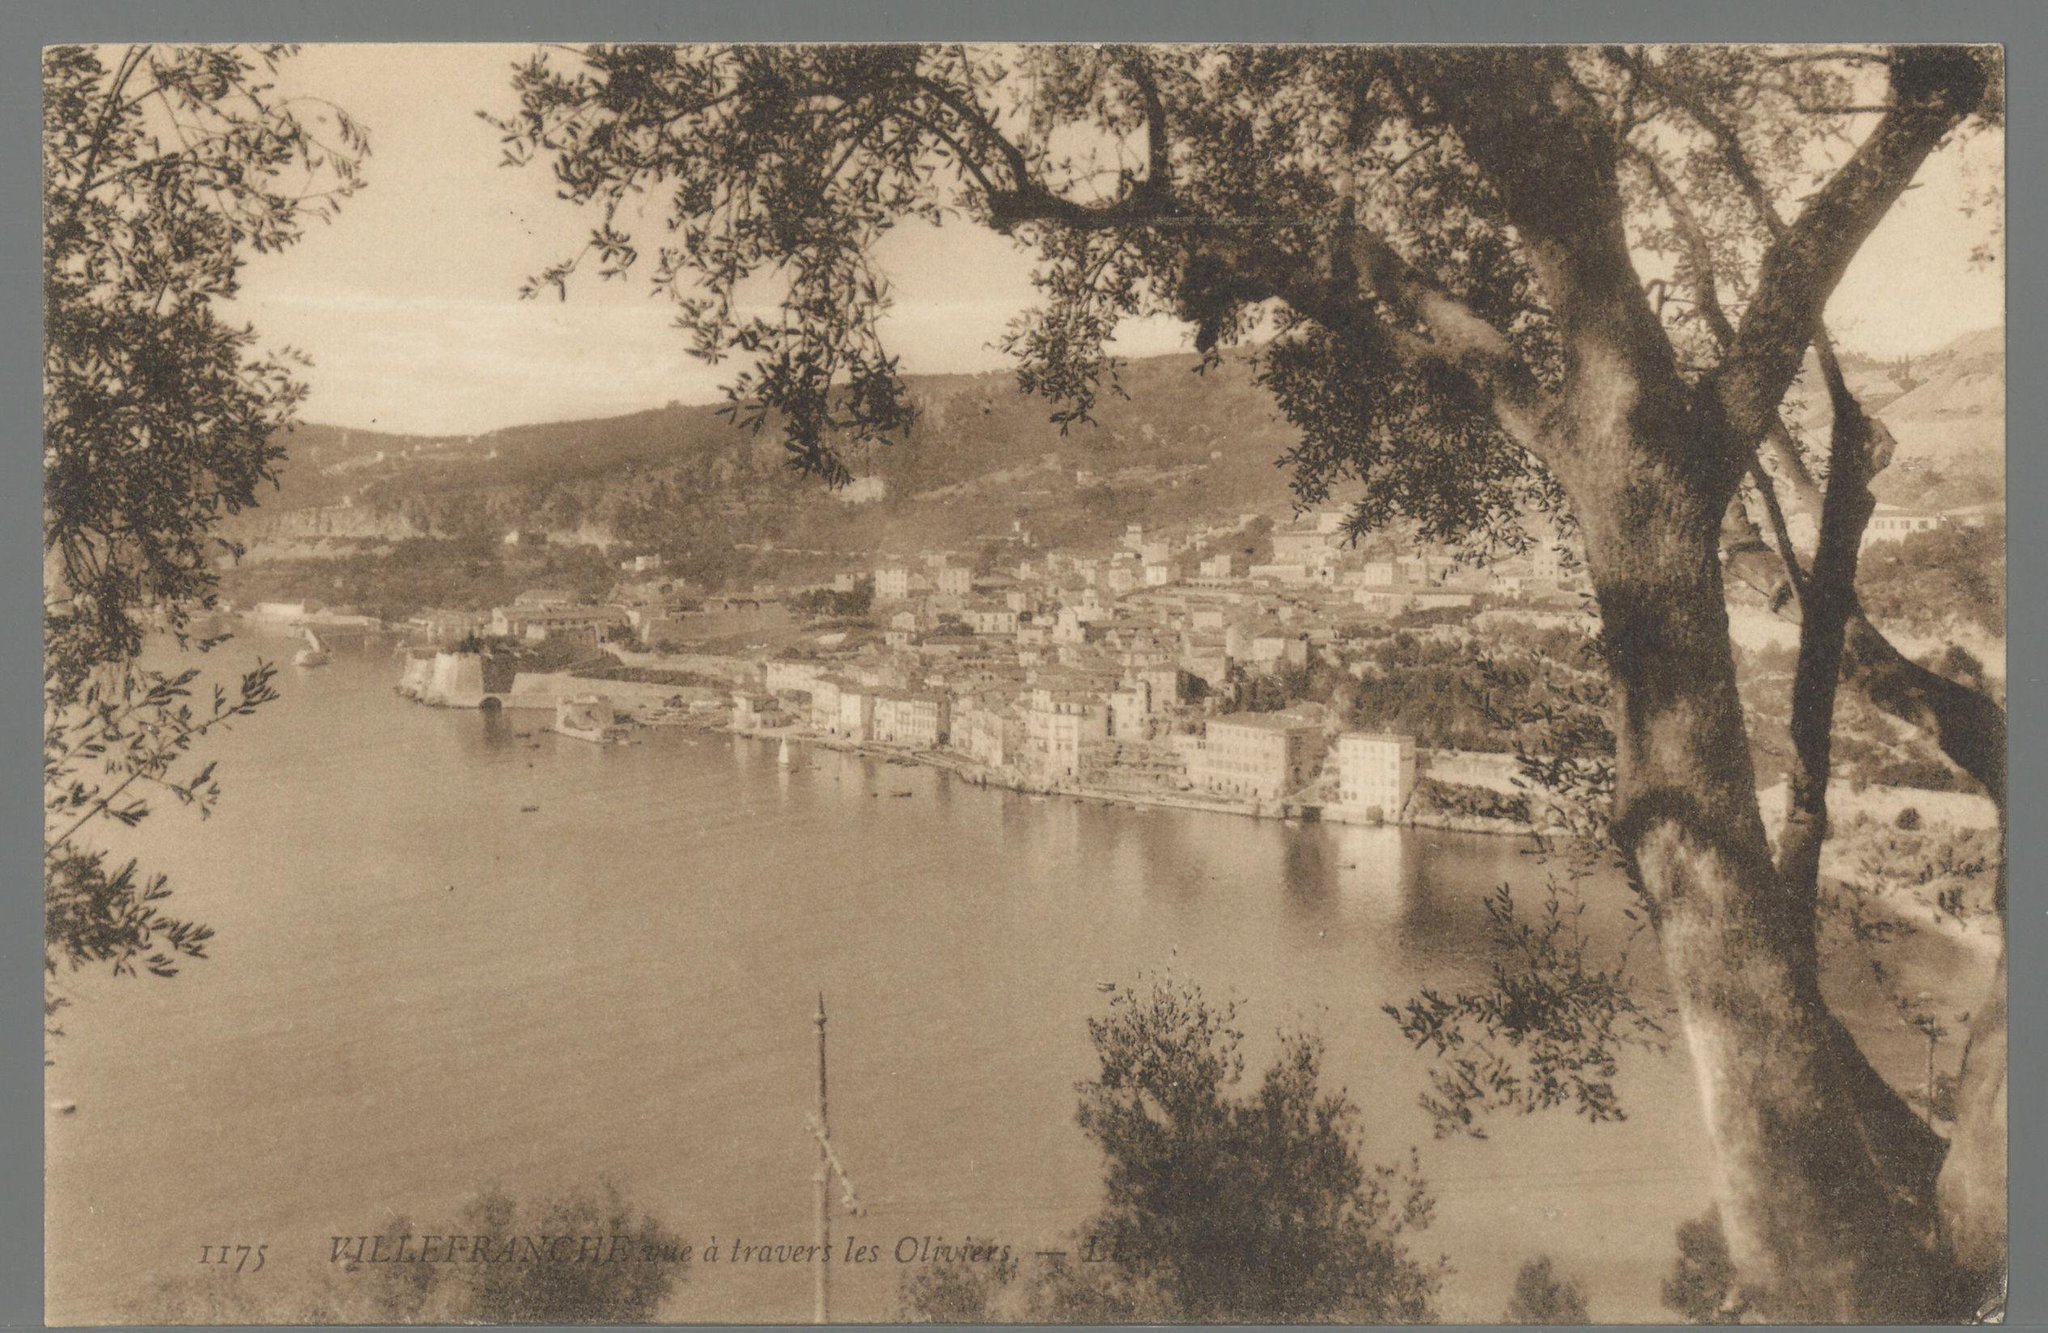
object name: photomechanical print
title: Villefranche vue à travers les Oliviers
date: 1904-1906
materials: cardboard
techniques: photograph, writing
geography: villefranche-sur-mer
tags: gulf, bay, prospect of village, silhouette of village, trees: olive-tree